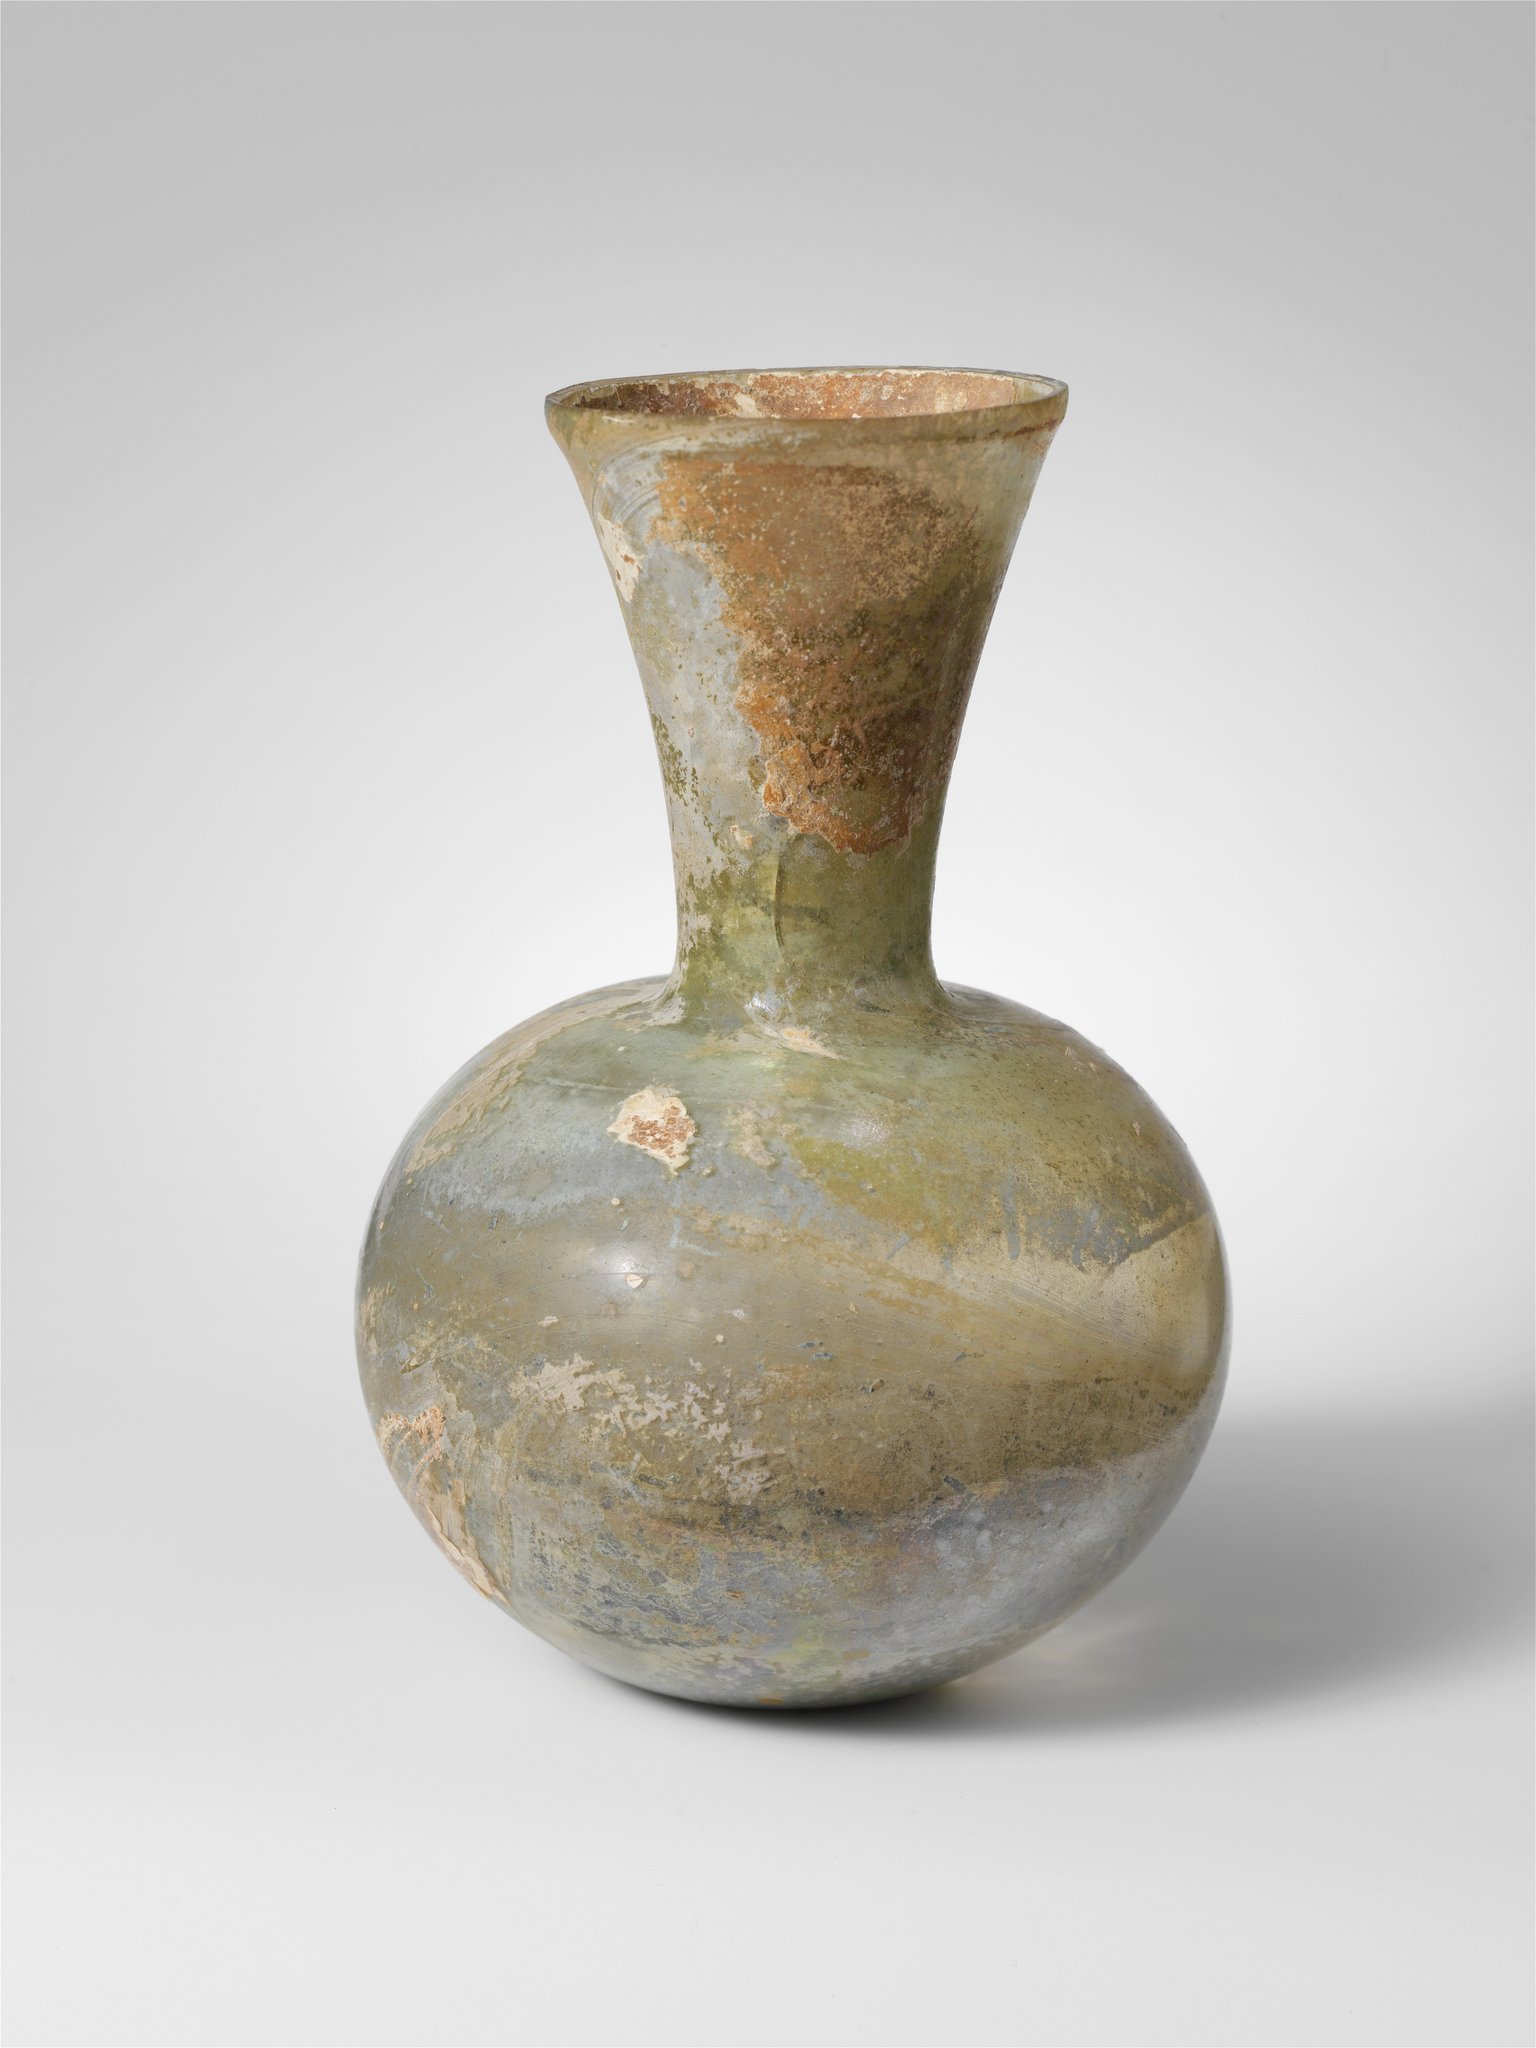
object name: bottle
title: Glass bottle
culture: roman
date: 301-400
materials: glass